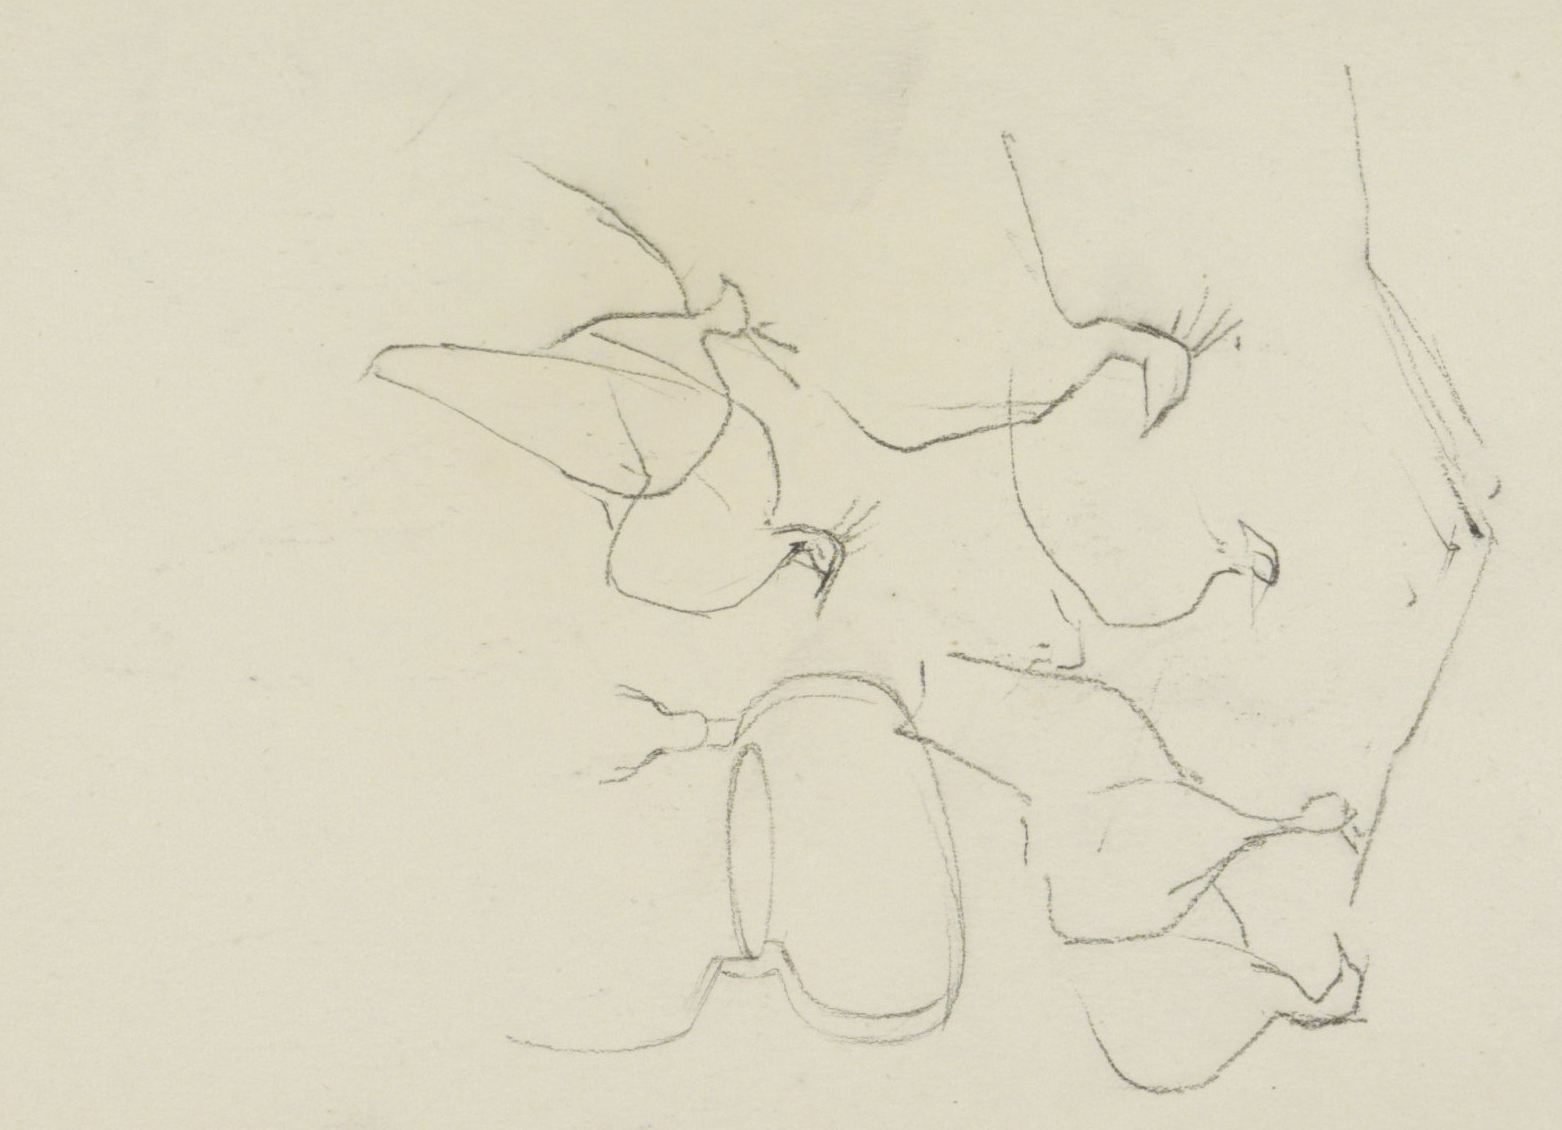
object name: sketchbook leaf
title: Vogels met een kuif en een pot met een hengsel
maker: a.a.l. de grammont-hubrecht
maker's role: draughtsman, painter, print maker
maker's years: 1855-1913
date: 1865-1913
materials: chalk, paper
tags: birds, container of ceramics: jar, jug, pot, vase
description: Blad 11 verso uit een schetsboek met 38 bladen.